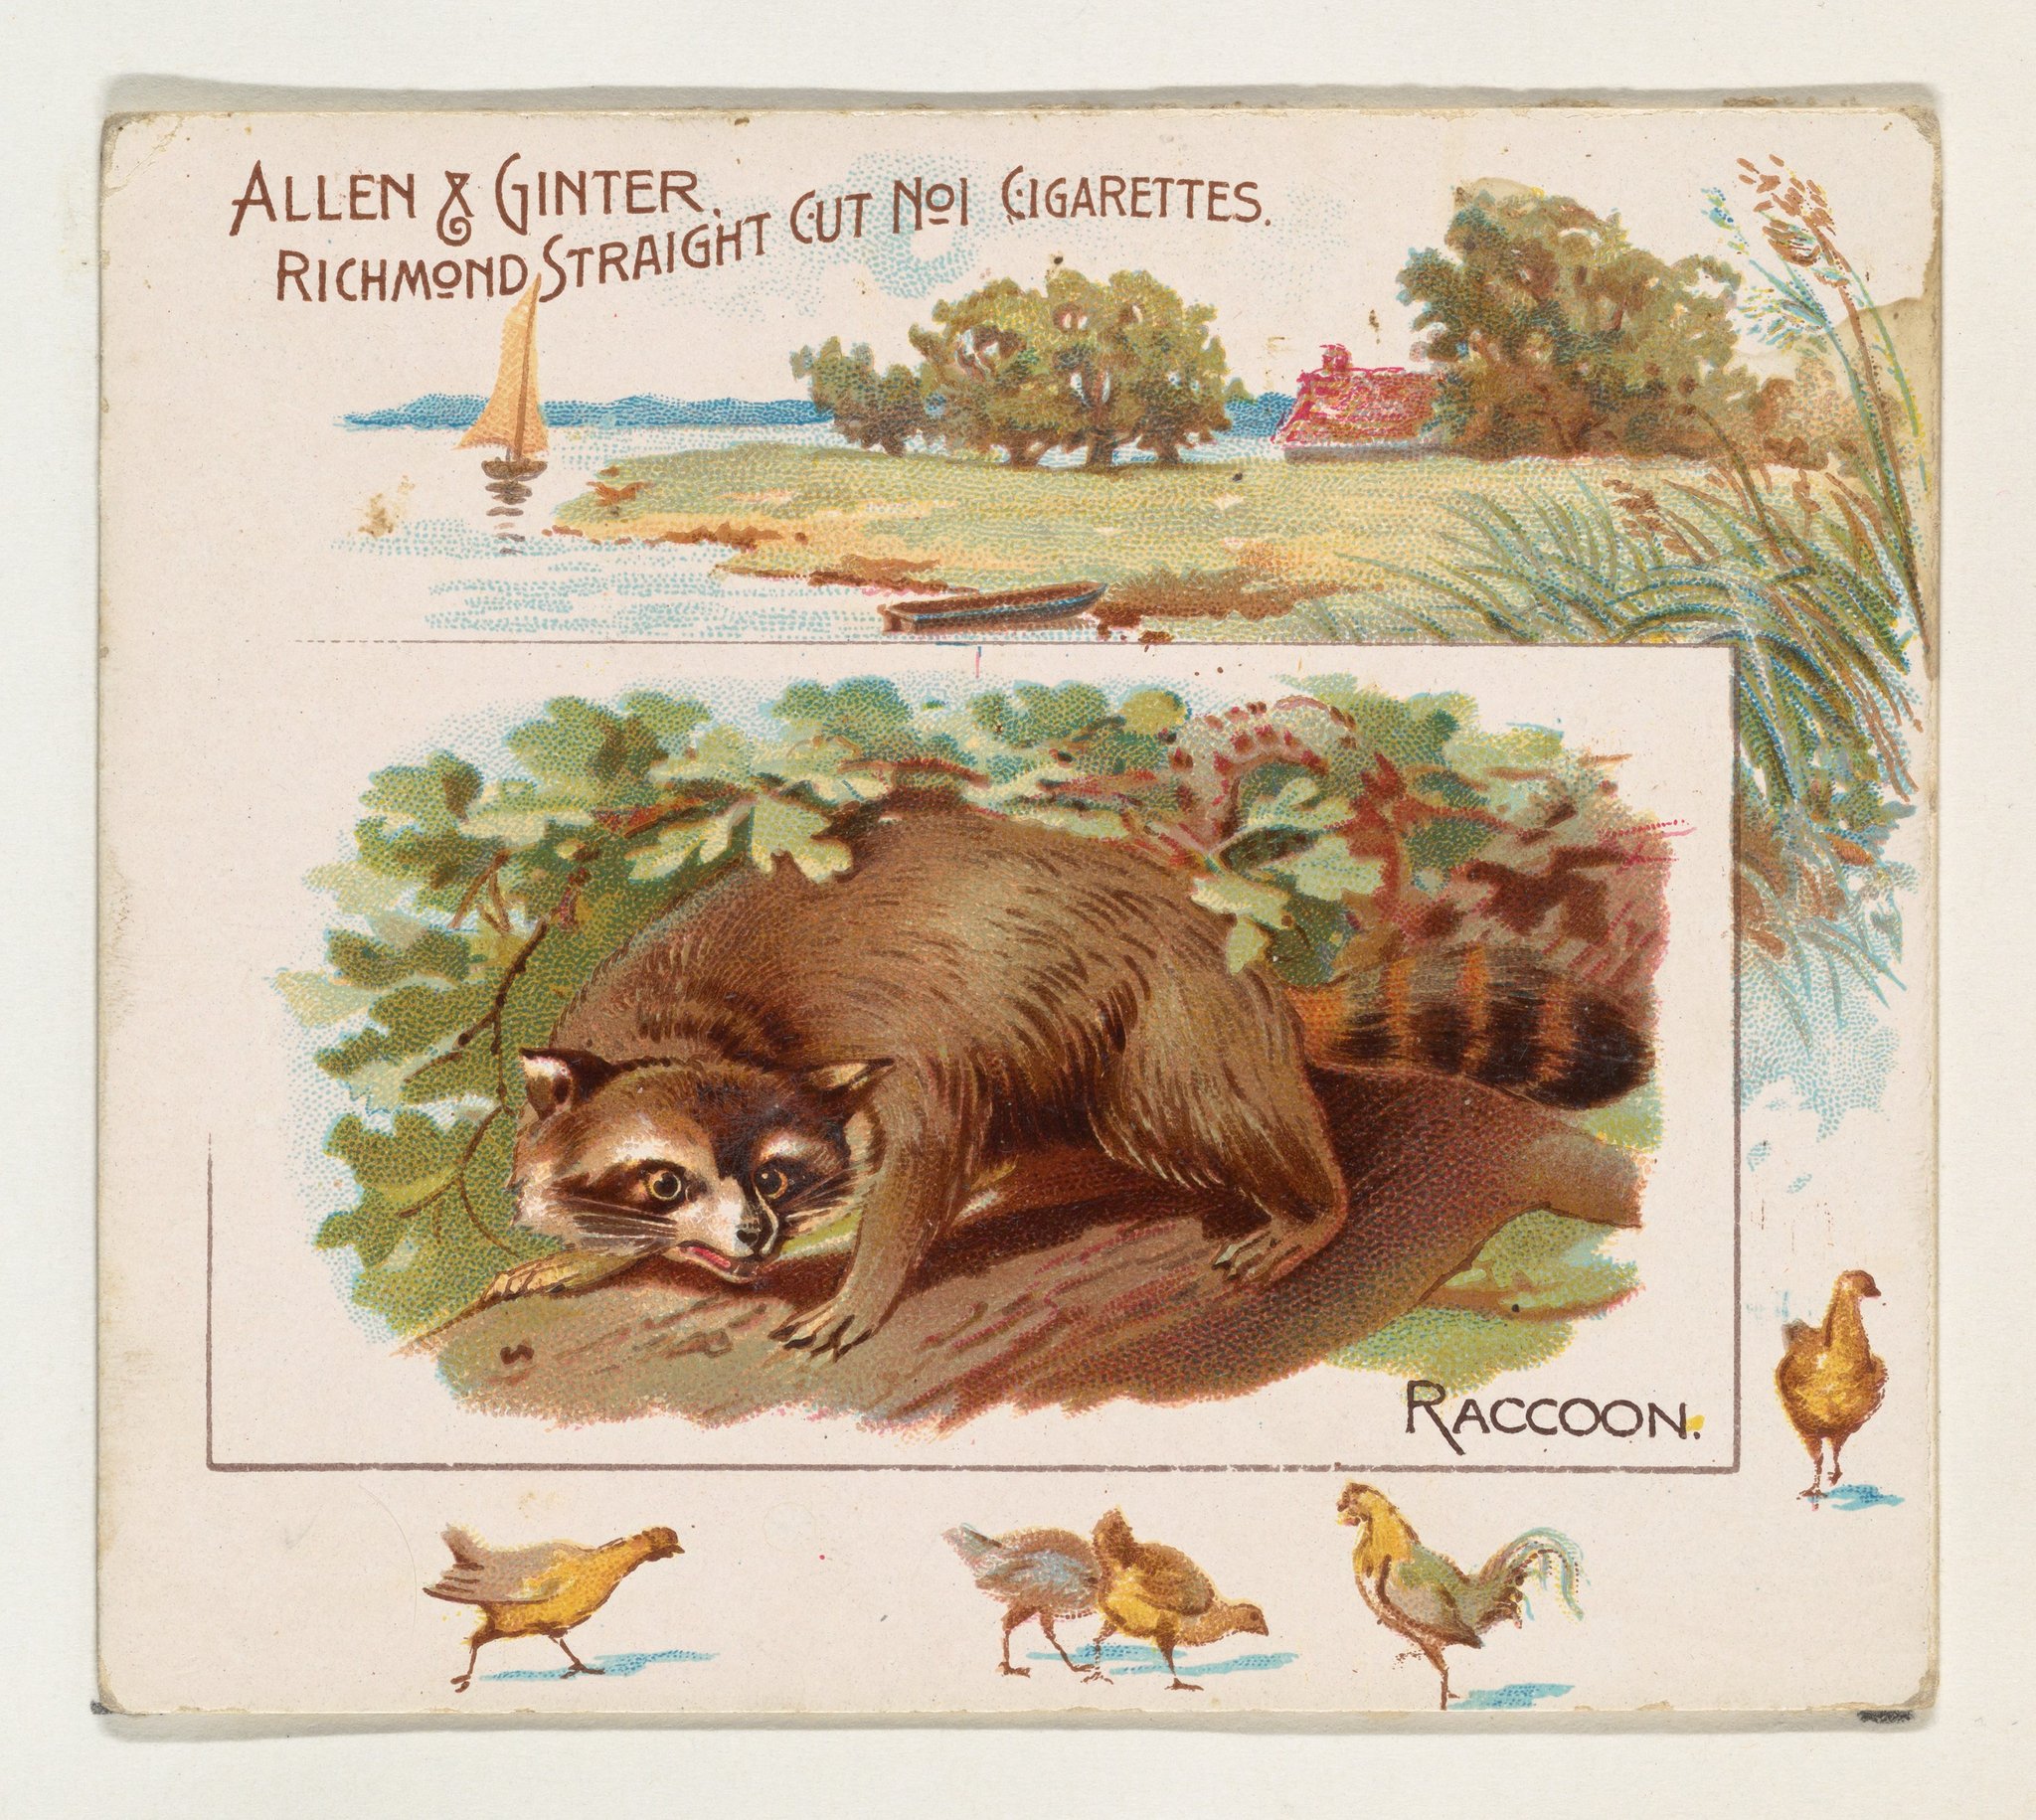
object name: print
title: Raccoon, from Quadrupeds series (N41) for Allen & Ginter Cigarettes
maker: allen & ginter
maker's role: publisher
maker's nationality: american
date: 1890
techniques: color lithograph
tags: animals,chickens